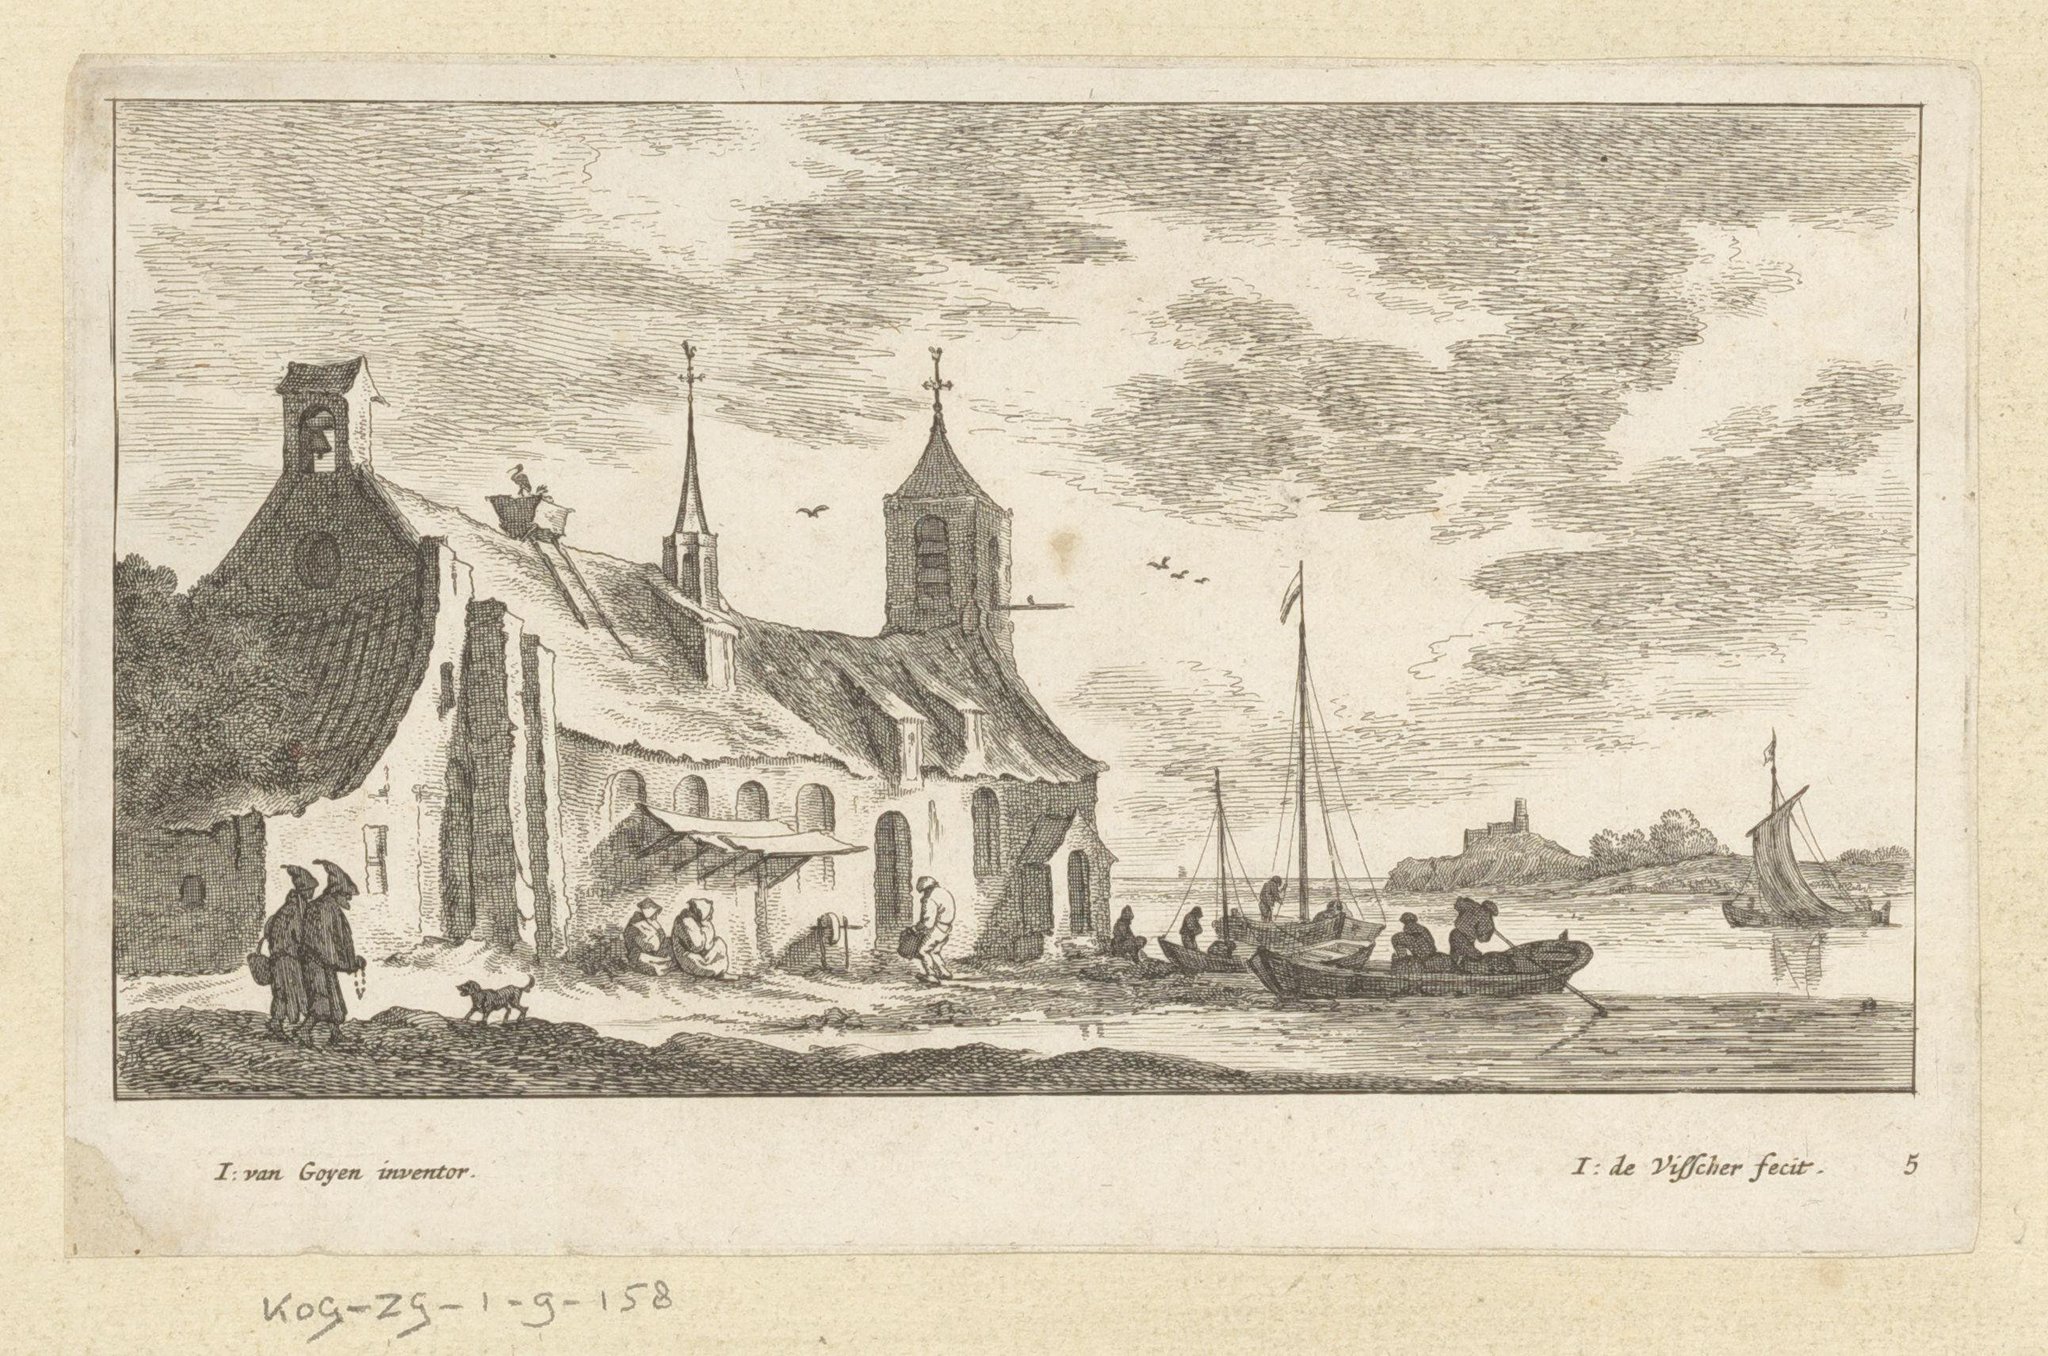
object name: print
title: Rivierlandschap met molen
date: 1682-1709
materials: paper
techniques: engraving, etching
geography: amsterdam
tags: sailing-ship, sailing-boat, river, church (exterior), windmill in landscape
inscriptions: stamp, collector's mark: Lugt 1641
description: Gezicht op een rivierlandschap met verschillende boten en op de achtergrond een toren en een molen. Onderwerpsrubrieken binnen de Atlas Zeden en Gewoonten: Handel, nijverheid en verkeer, Buitenleven.